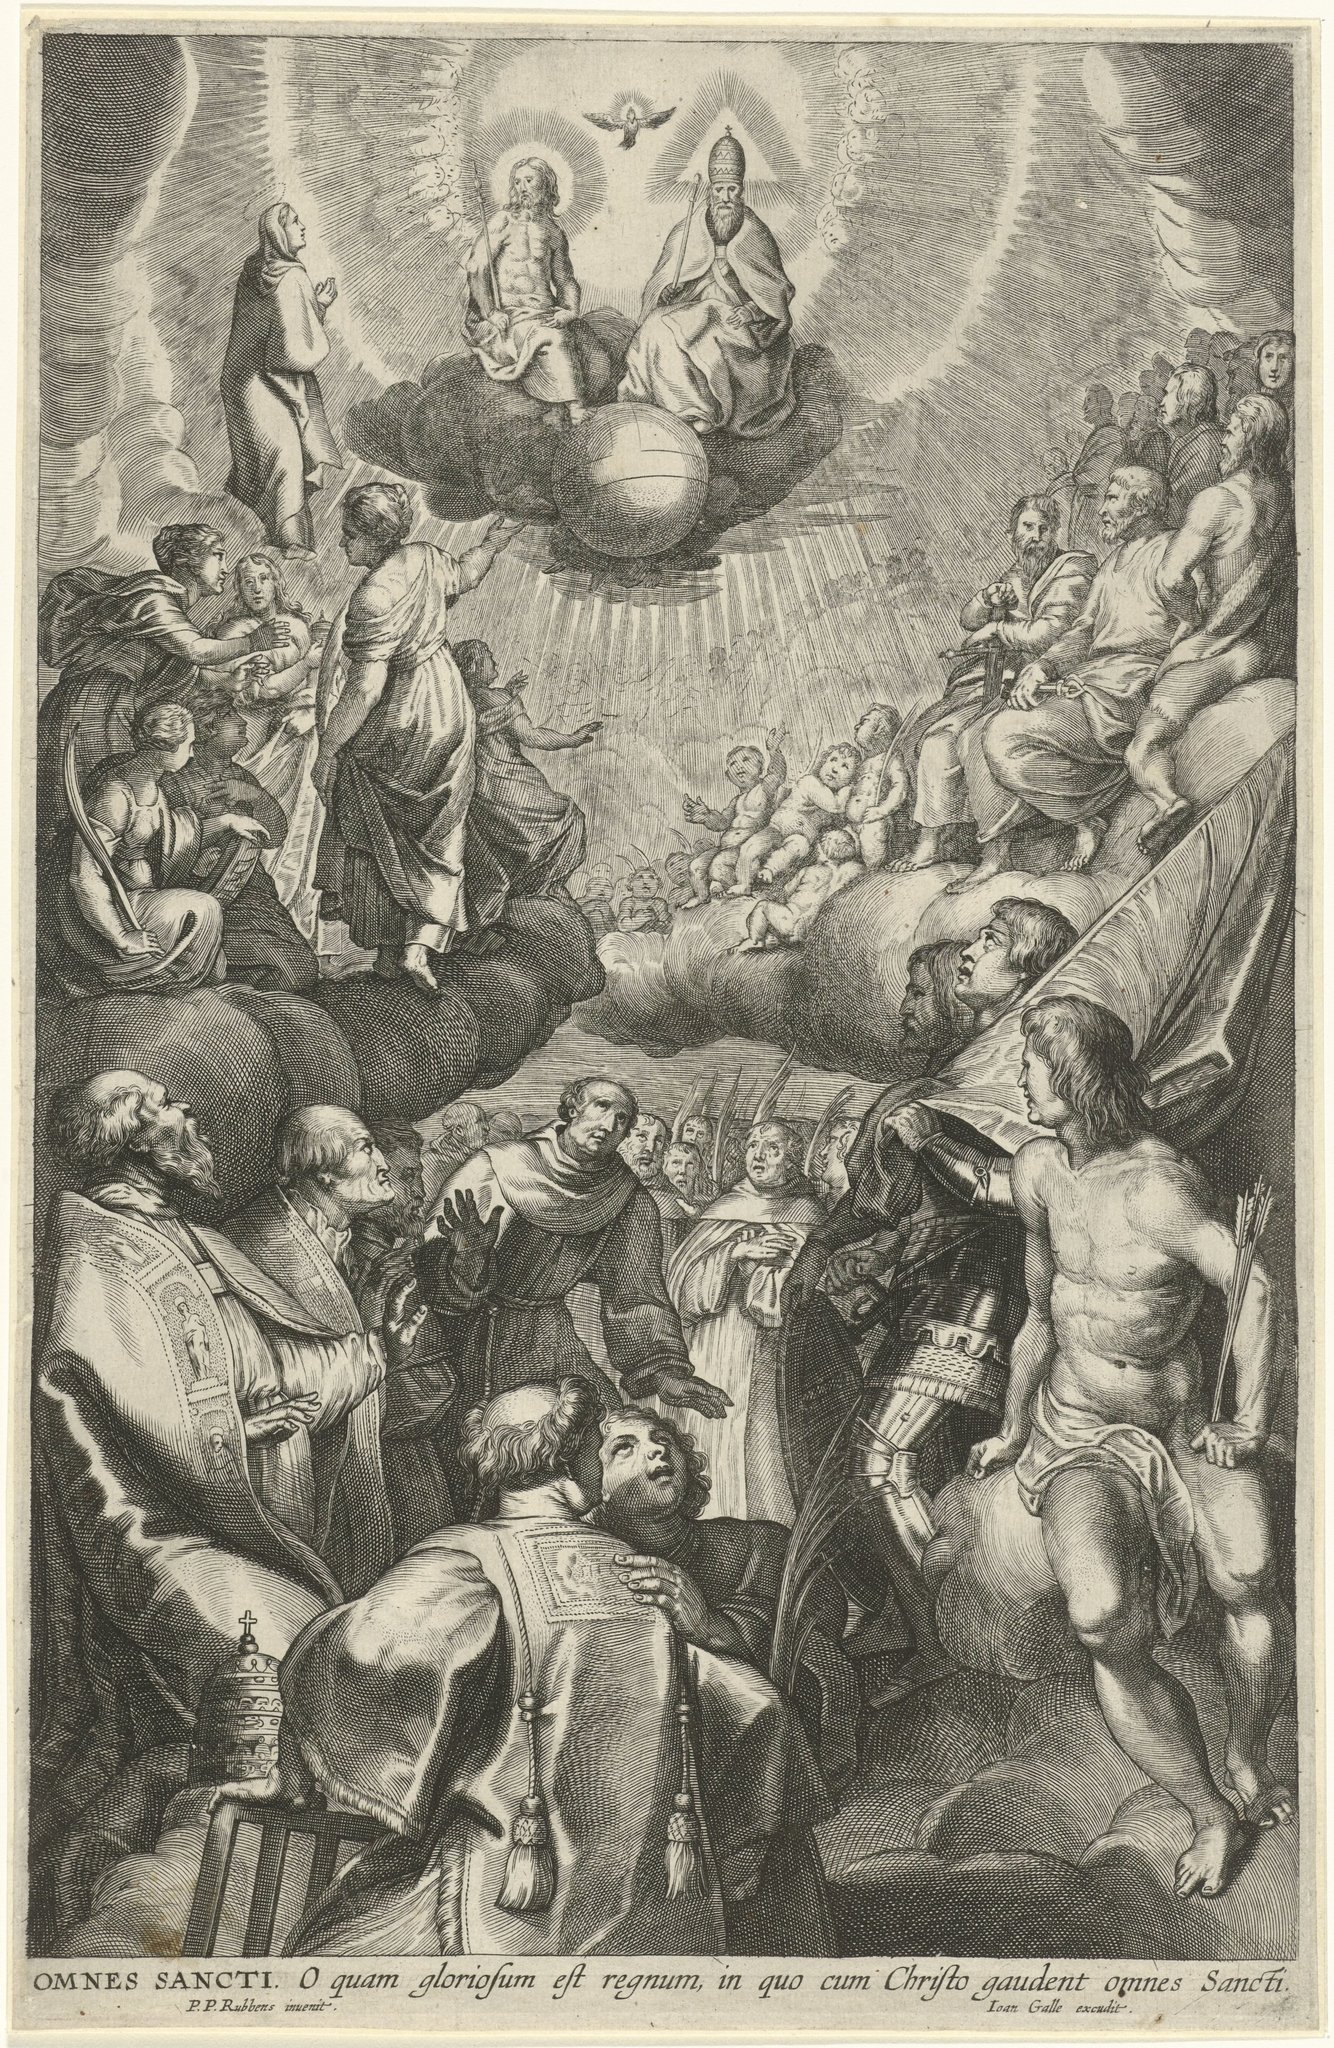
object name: print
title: Allerheiligenvoorstelling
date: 1614-1676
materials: paper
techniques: engraving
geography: antwerp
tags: devotion: all saints picture, 'allerheiligenbild'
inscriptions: collector's mark: Lugt 240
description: Rondom de tronende Drieëenheid van Christus, God en de Heilige Geest zijn alle heiligen verzameld (o.a. de H. Sebastiaan, de H. Joris. de H. Catherina van Constantinopel, etc.). Maria staat naast de Drieëenheid. De prent heeft een Latijns onderschrift.